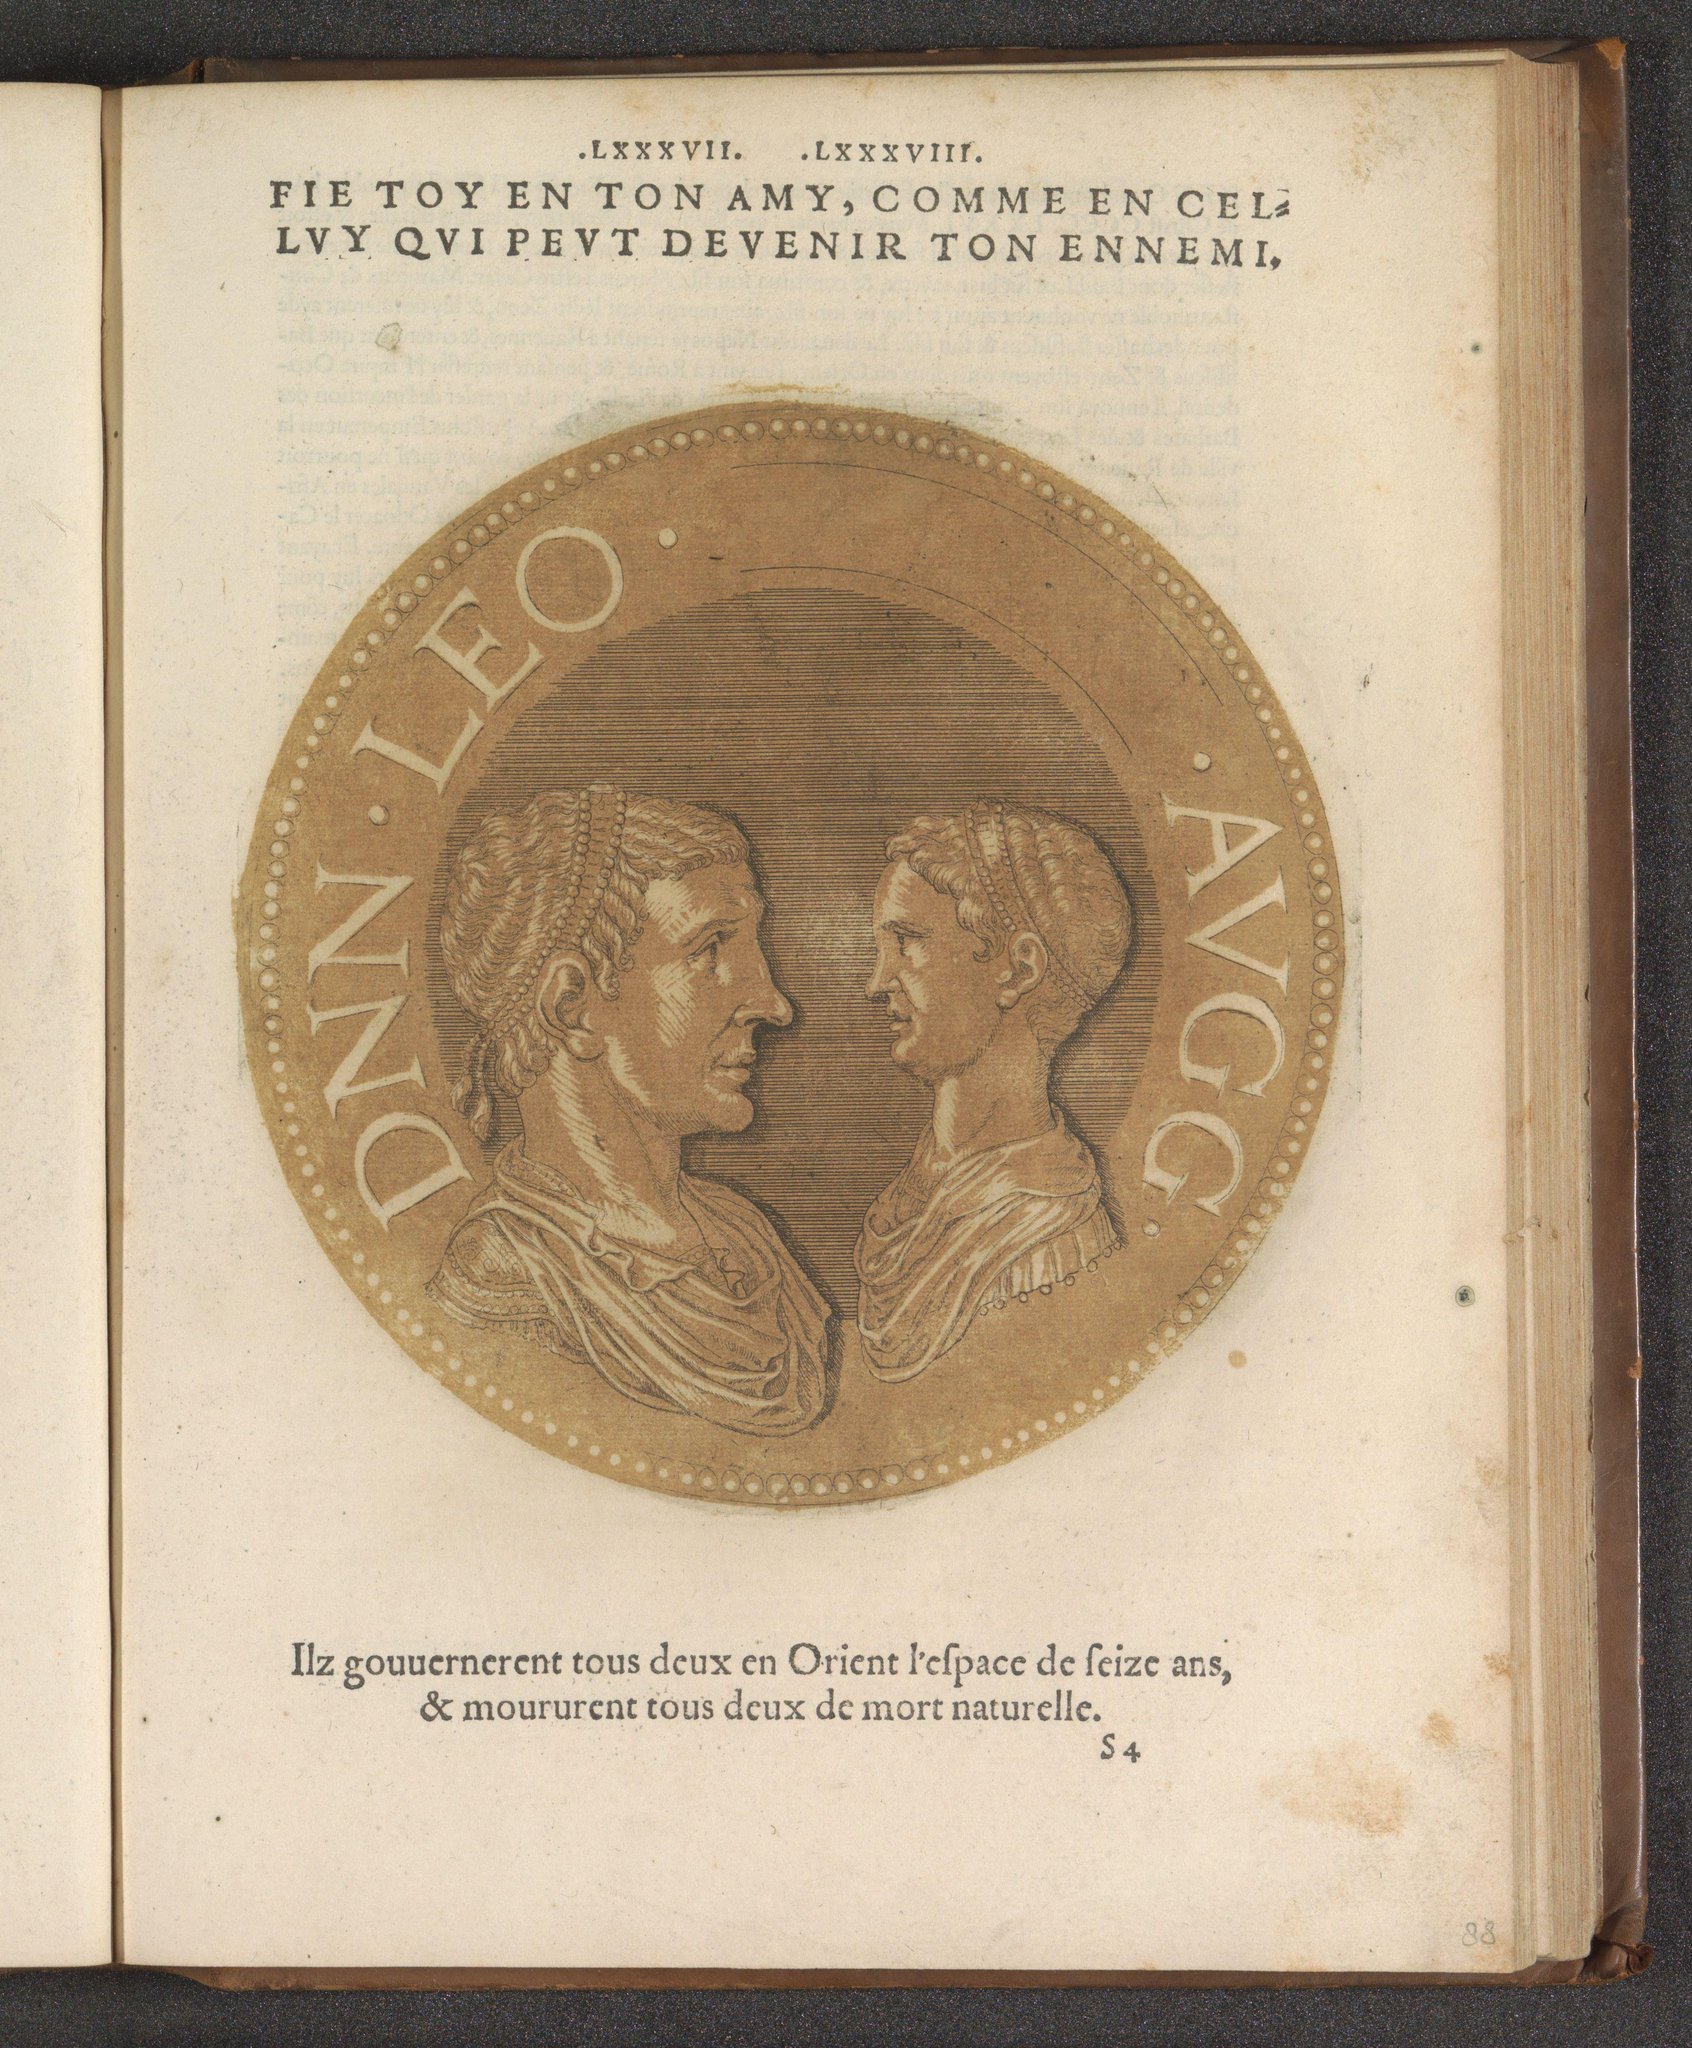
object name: page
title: Les images presque de tous les empereurs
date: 1557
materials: paper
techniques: woodcut, etching, letterpress printing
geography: antwerp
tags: emperor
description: Portretten van keizer Leo I en zijn kleinzoon Leo II, samen op een munt met randschrift. De prent maakt deel uit van een boek over de keizers vanaf Julius Caesar tot en met Karel V en zijn broer Ferdinand.